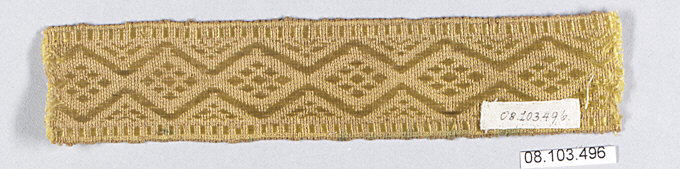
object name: galloon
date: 1701-1800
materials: cotton, silk